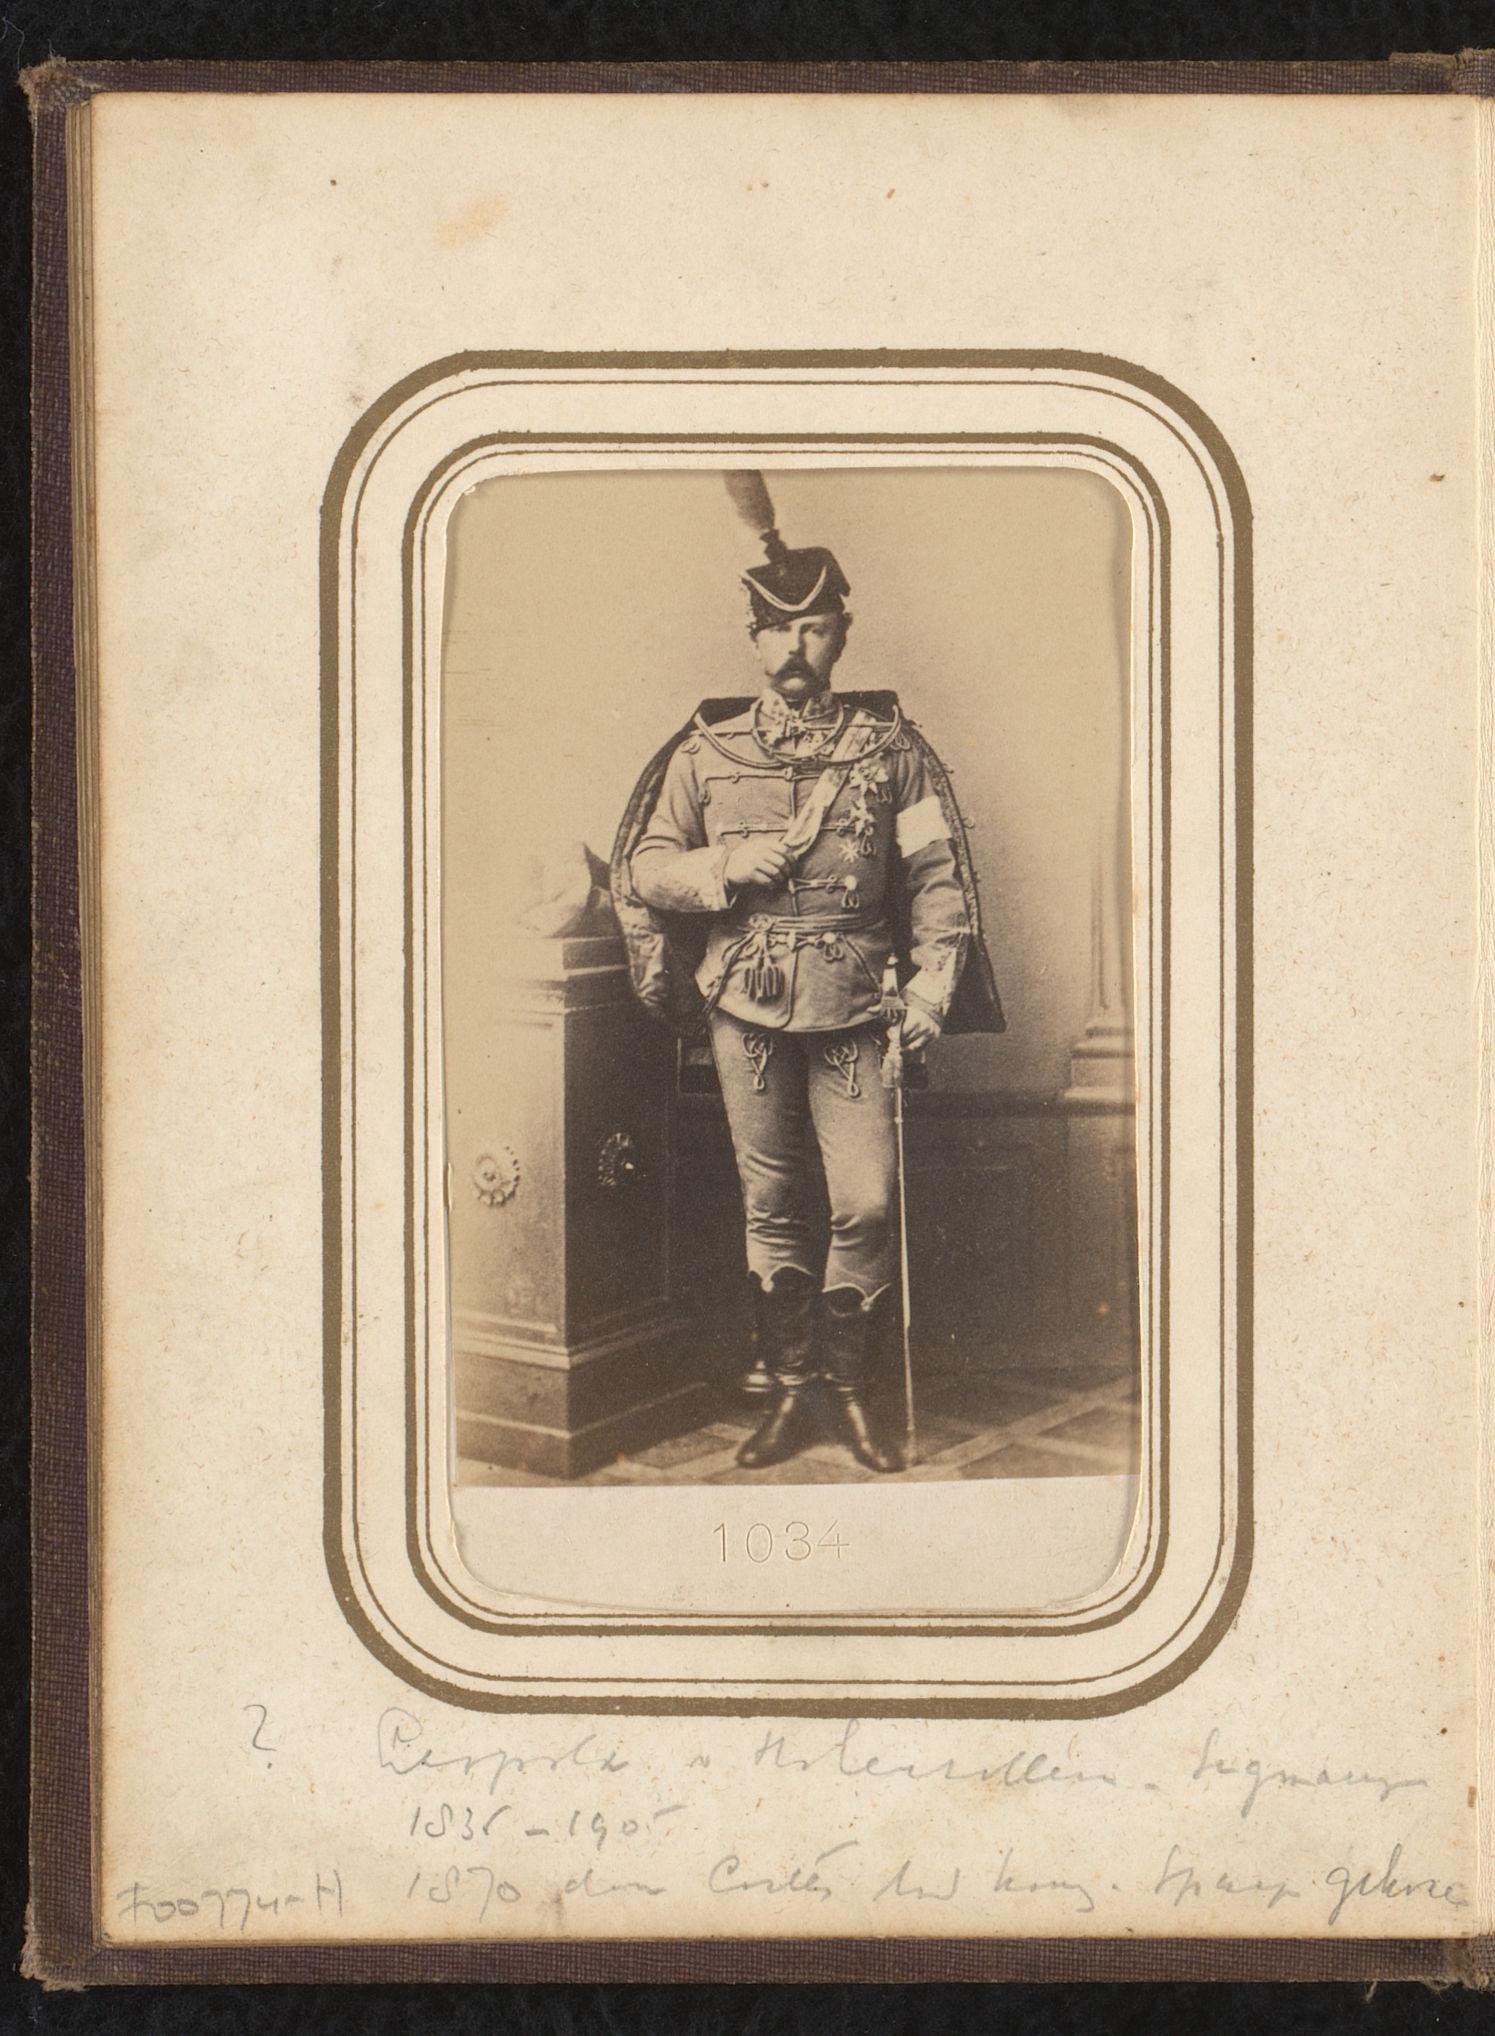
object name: album leaf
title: Portret van Leopold van Hohenzollern in uniform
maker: Anonymous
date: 1870-1890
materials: cardboard, photographic support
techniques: albumen print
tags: emperor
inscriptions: annotation: ‘? Leopold v Hohenzollern-Sigmaringen/ 1835-1905/ 1870 d[...], en koning Spanje gek[..]’, number: ‘1034’